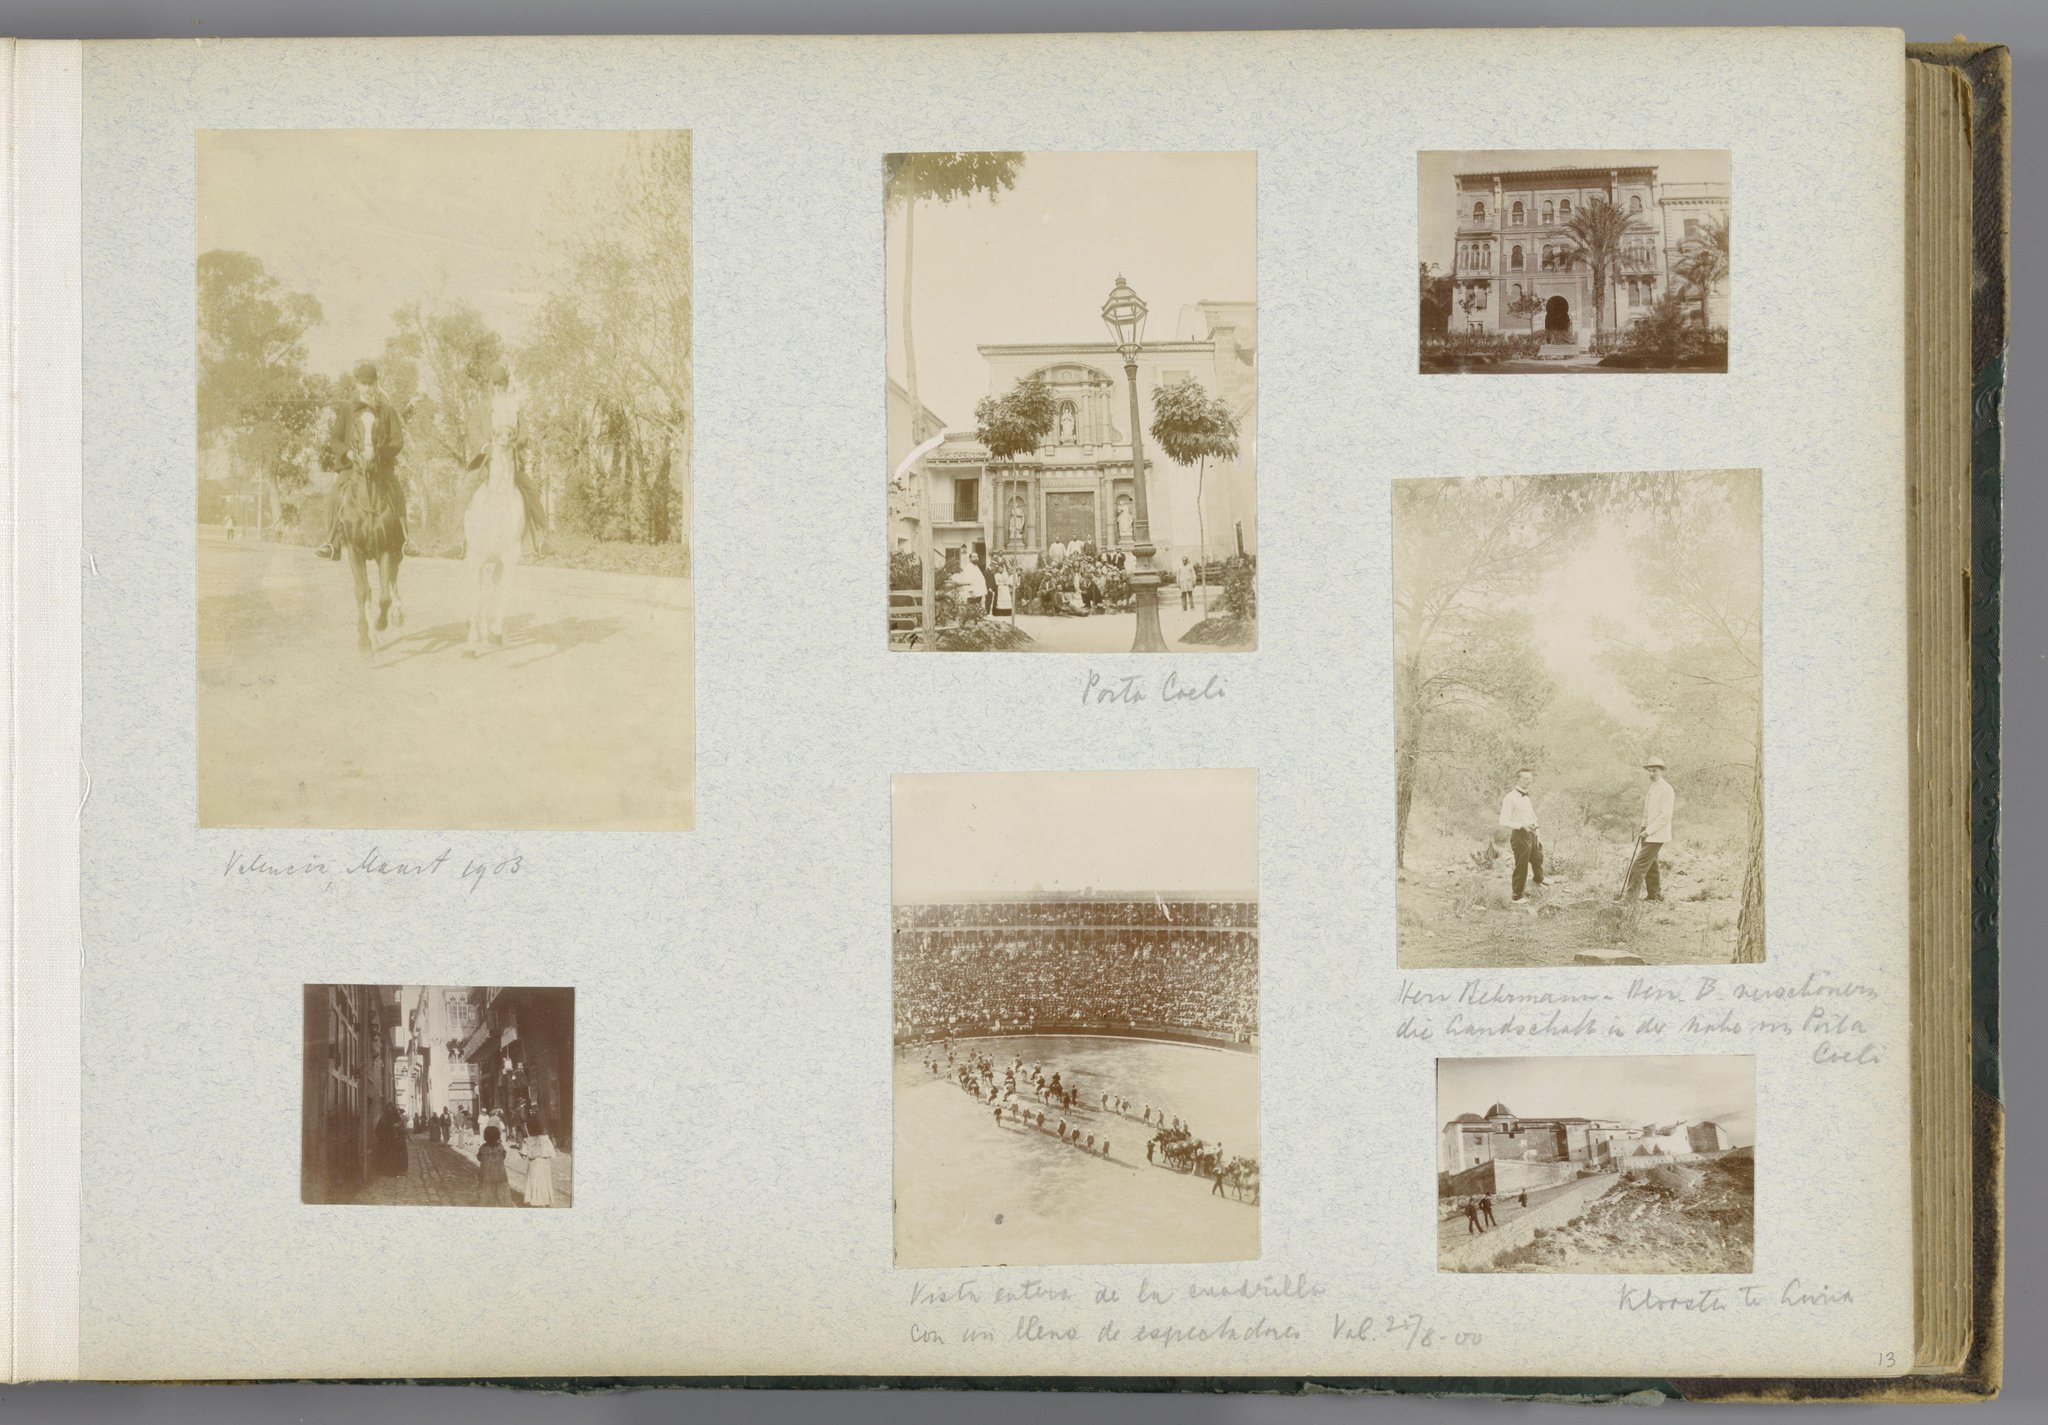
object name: photograph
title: Albumblad met zeven foto's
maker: andries augustus boom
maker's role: amateurfotograaf, handelaar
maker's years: 1878-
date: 1900-1903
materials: paper, photographic support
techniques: photography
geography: spain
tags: amsterdam, andries augustus boom, spain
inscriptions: date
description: Albumblad met zeven foto's in Spanje, o.a. in Valencia en Porta Coeli, 1900 en 1903. Onderdeel van het fotoalbum van de familie Boom-Gonggrijp in Suriname en Curaçao.